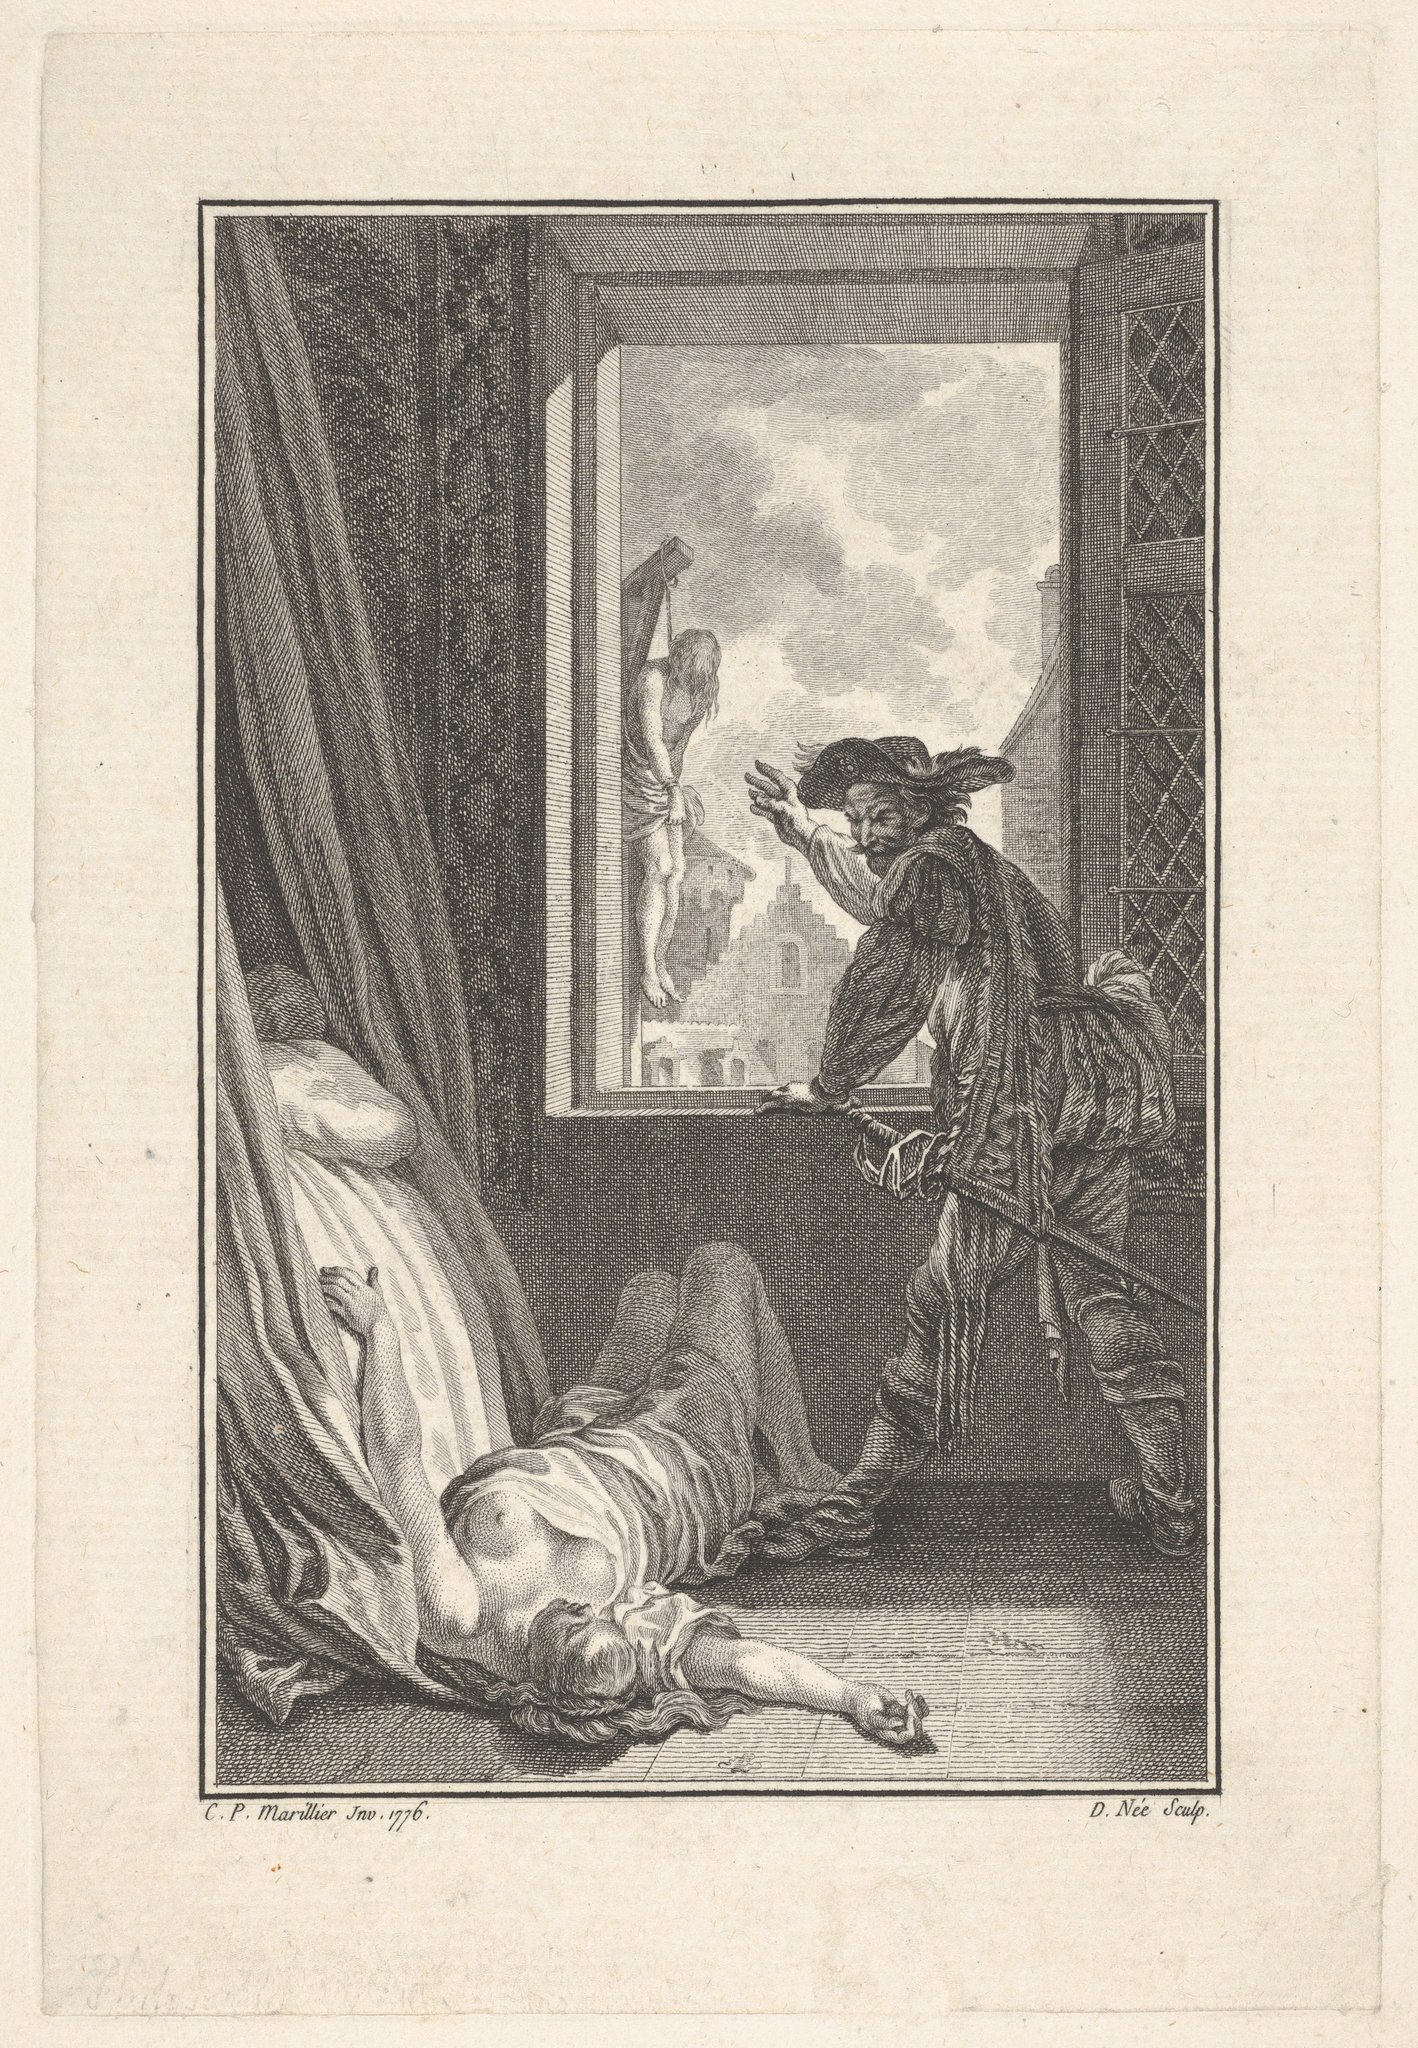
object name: print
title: Illustration for "Philosophie de la nature"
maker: françois denis née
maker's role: artist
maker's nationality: french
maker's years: 1732-1817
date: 1776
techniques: engraving, etching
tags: windows,men,female nudes